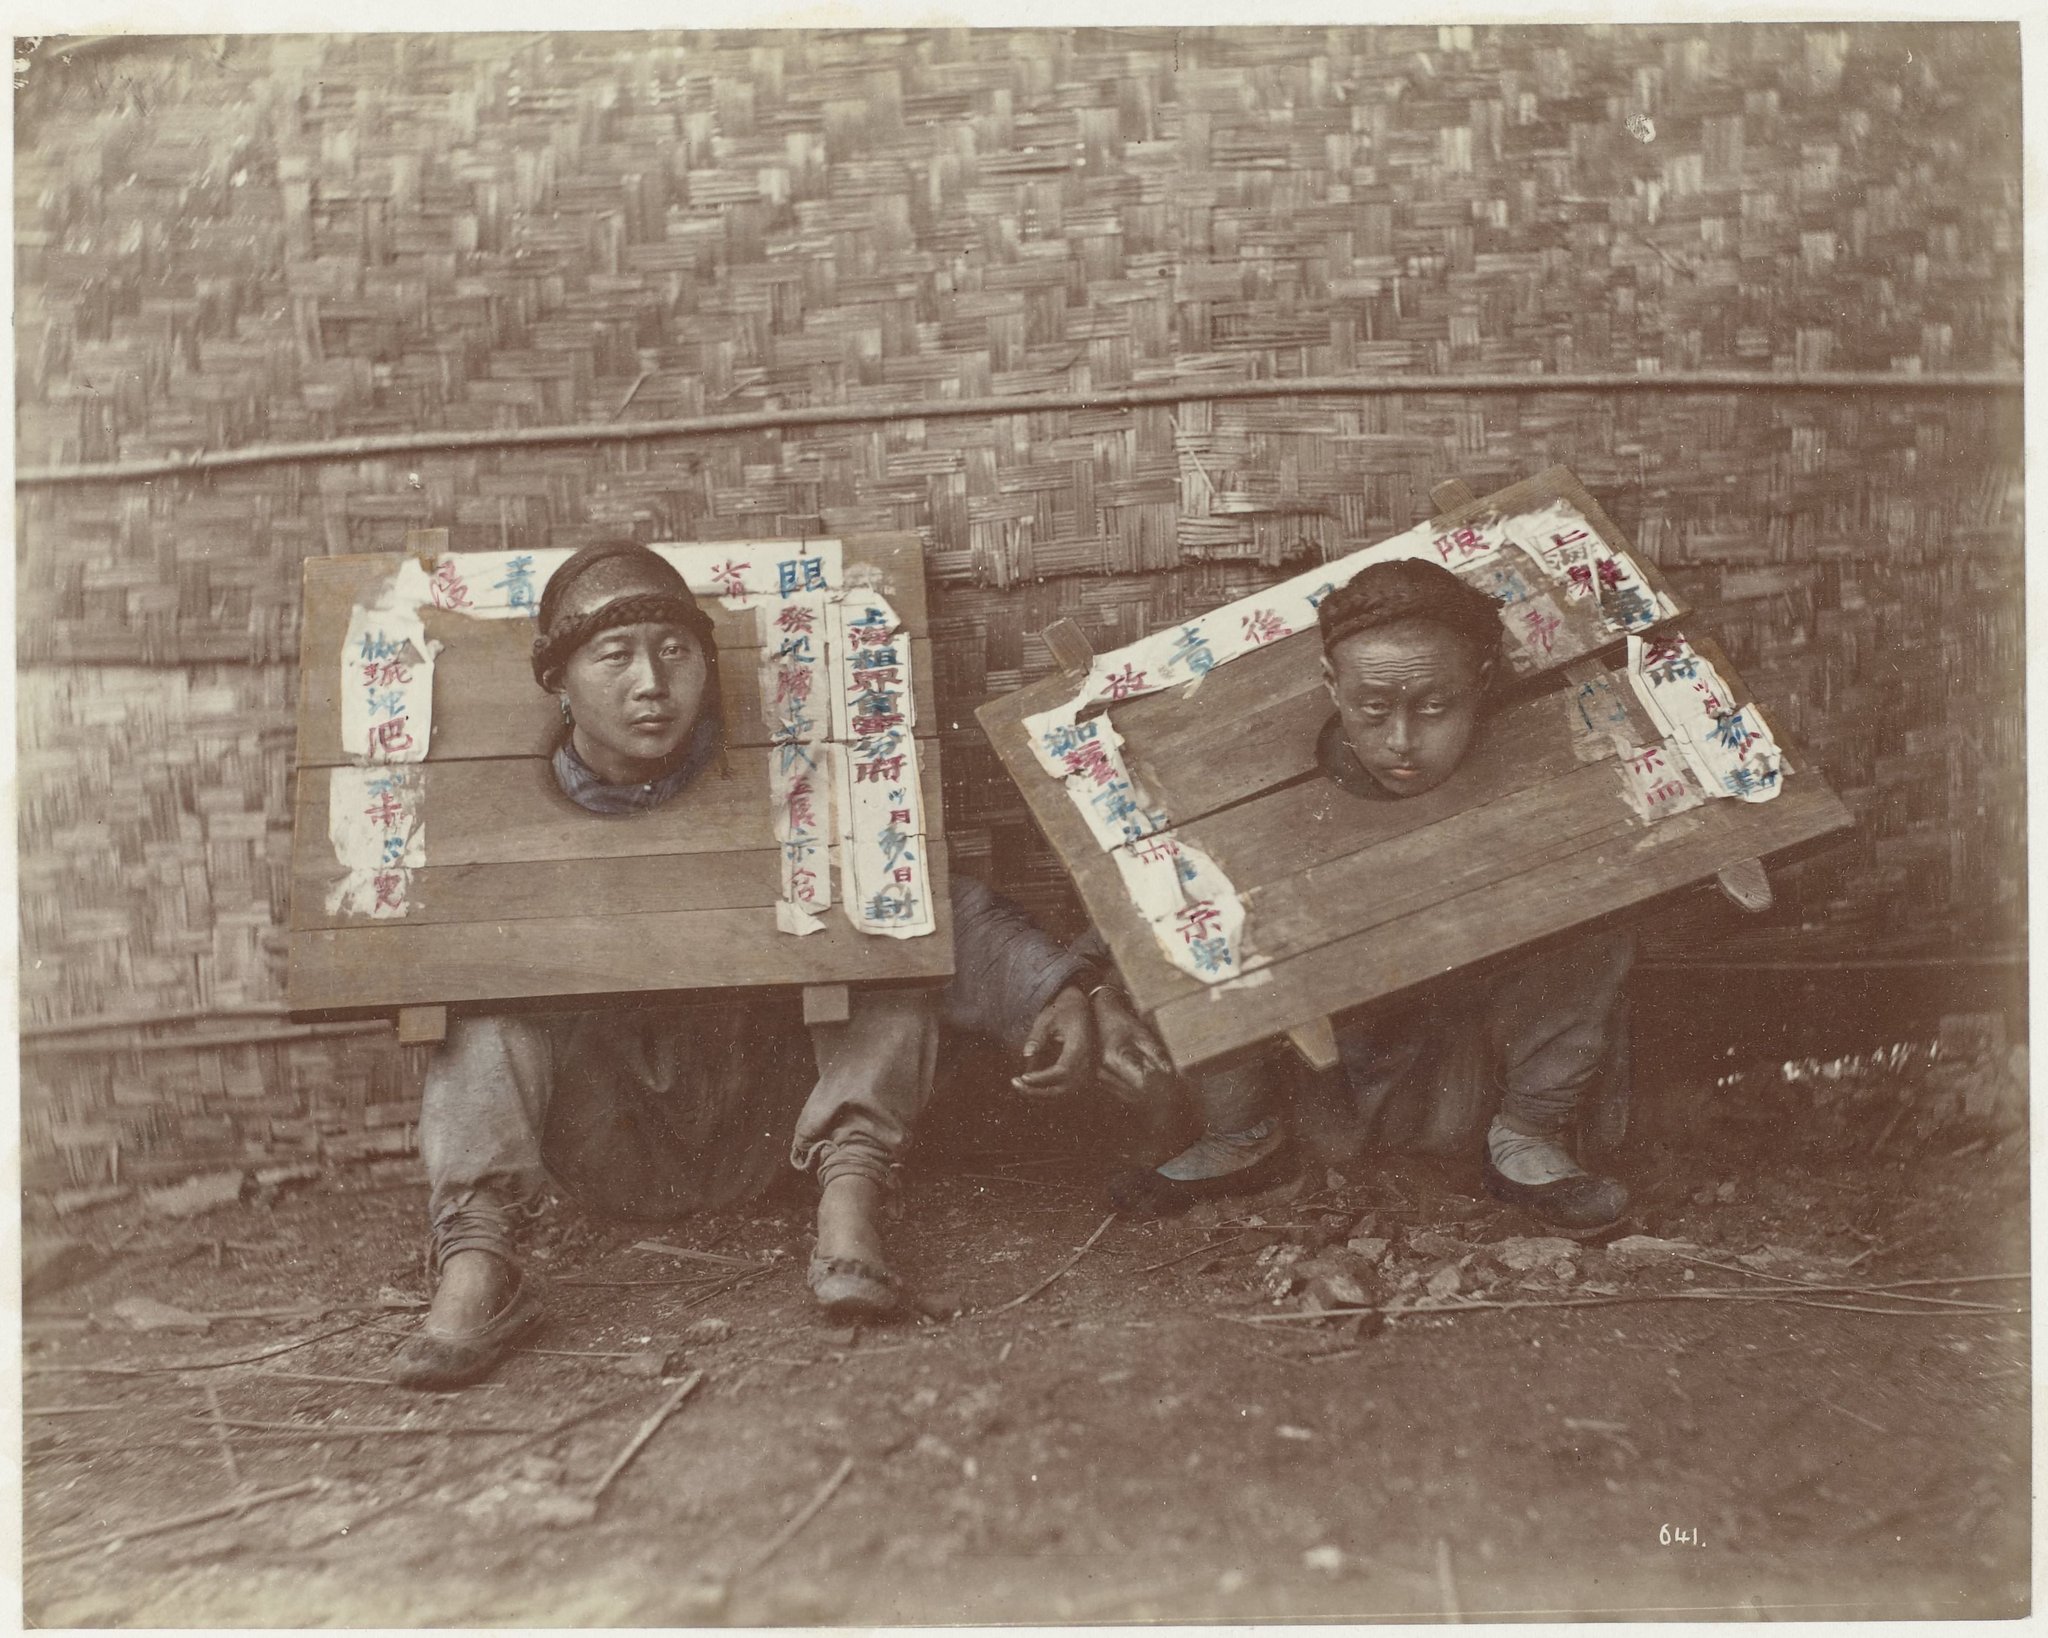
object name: photograph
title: Twee Chinese gevangenen met hun hoofden in houten borden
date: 1860-1885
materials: cardboard, photographic support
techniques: albumen print, hand coloring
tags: prisoner; in fetters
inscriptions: number: ‘641’, annotation: ‘Stillfried of Beato’